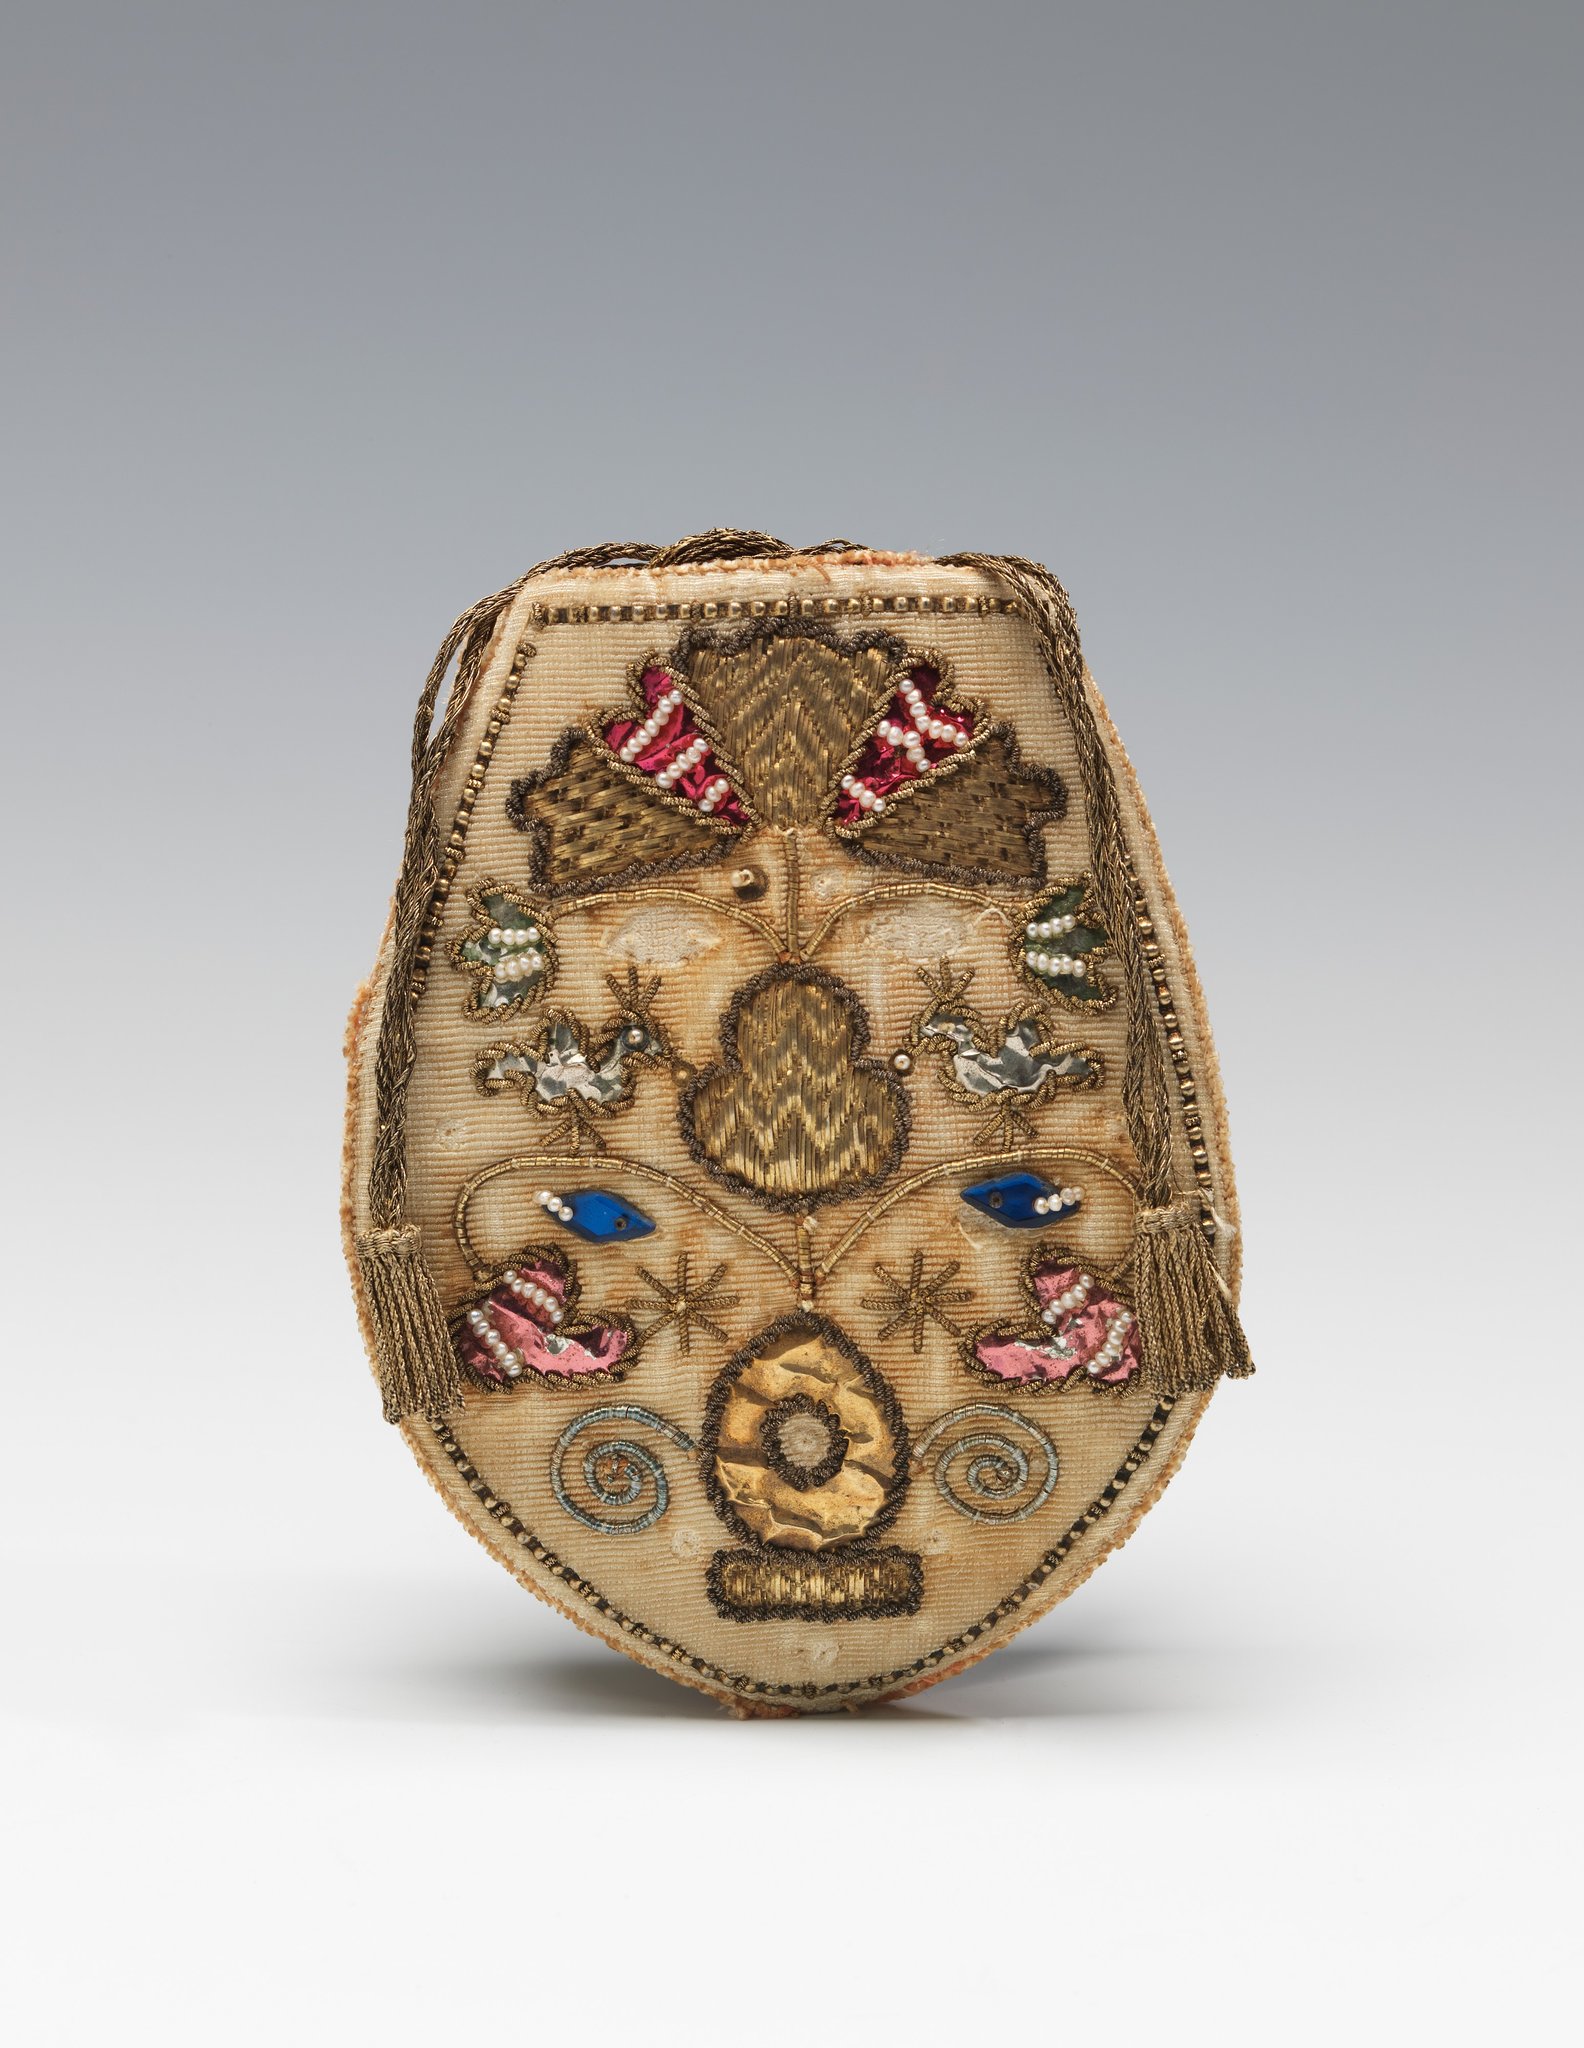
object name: pouch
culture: russian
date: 1701-1733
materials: metal, pearl, silk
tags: birds